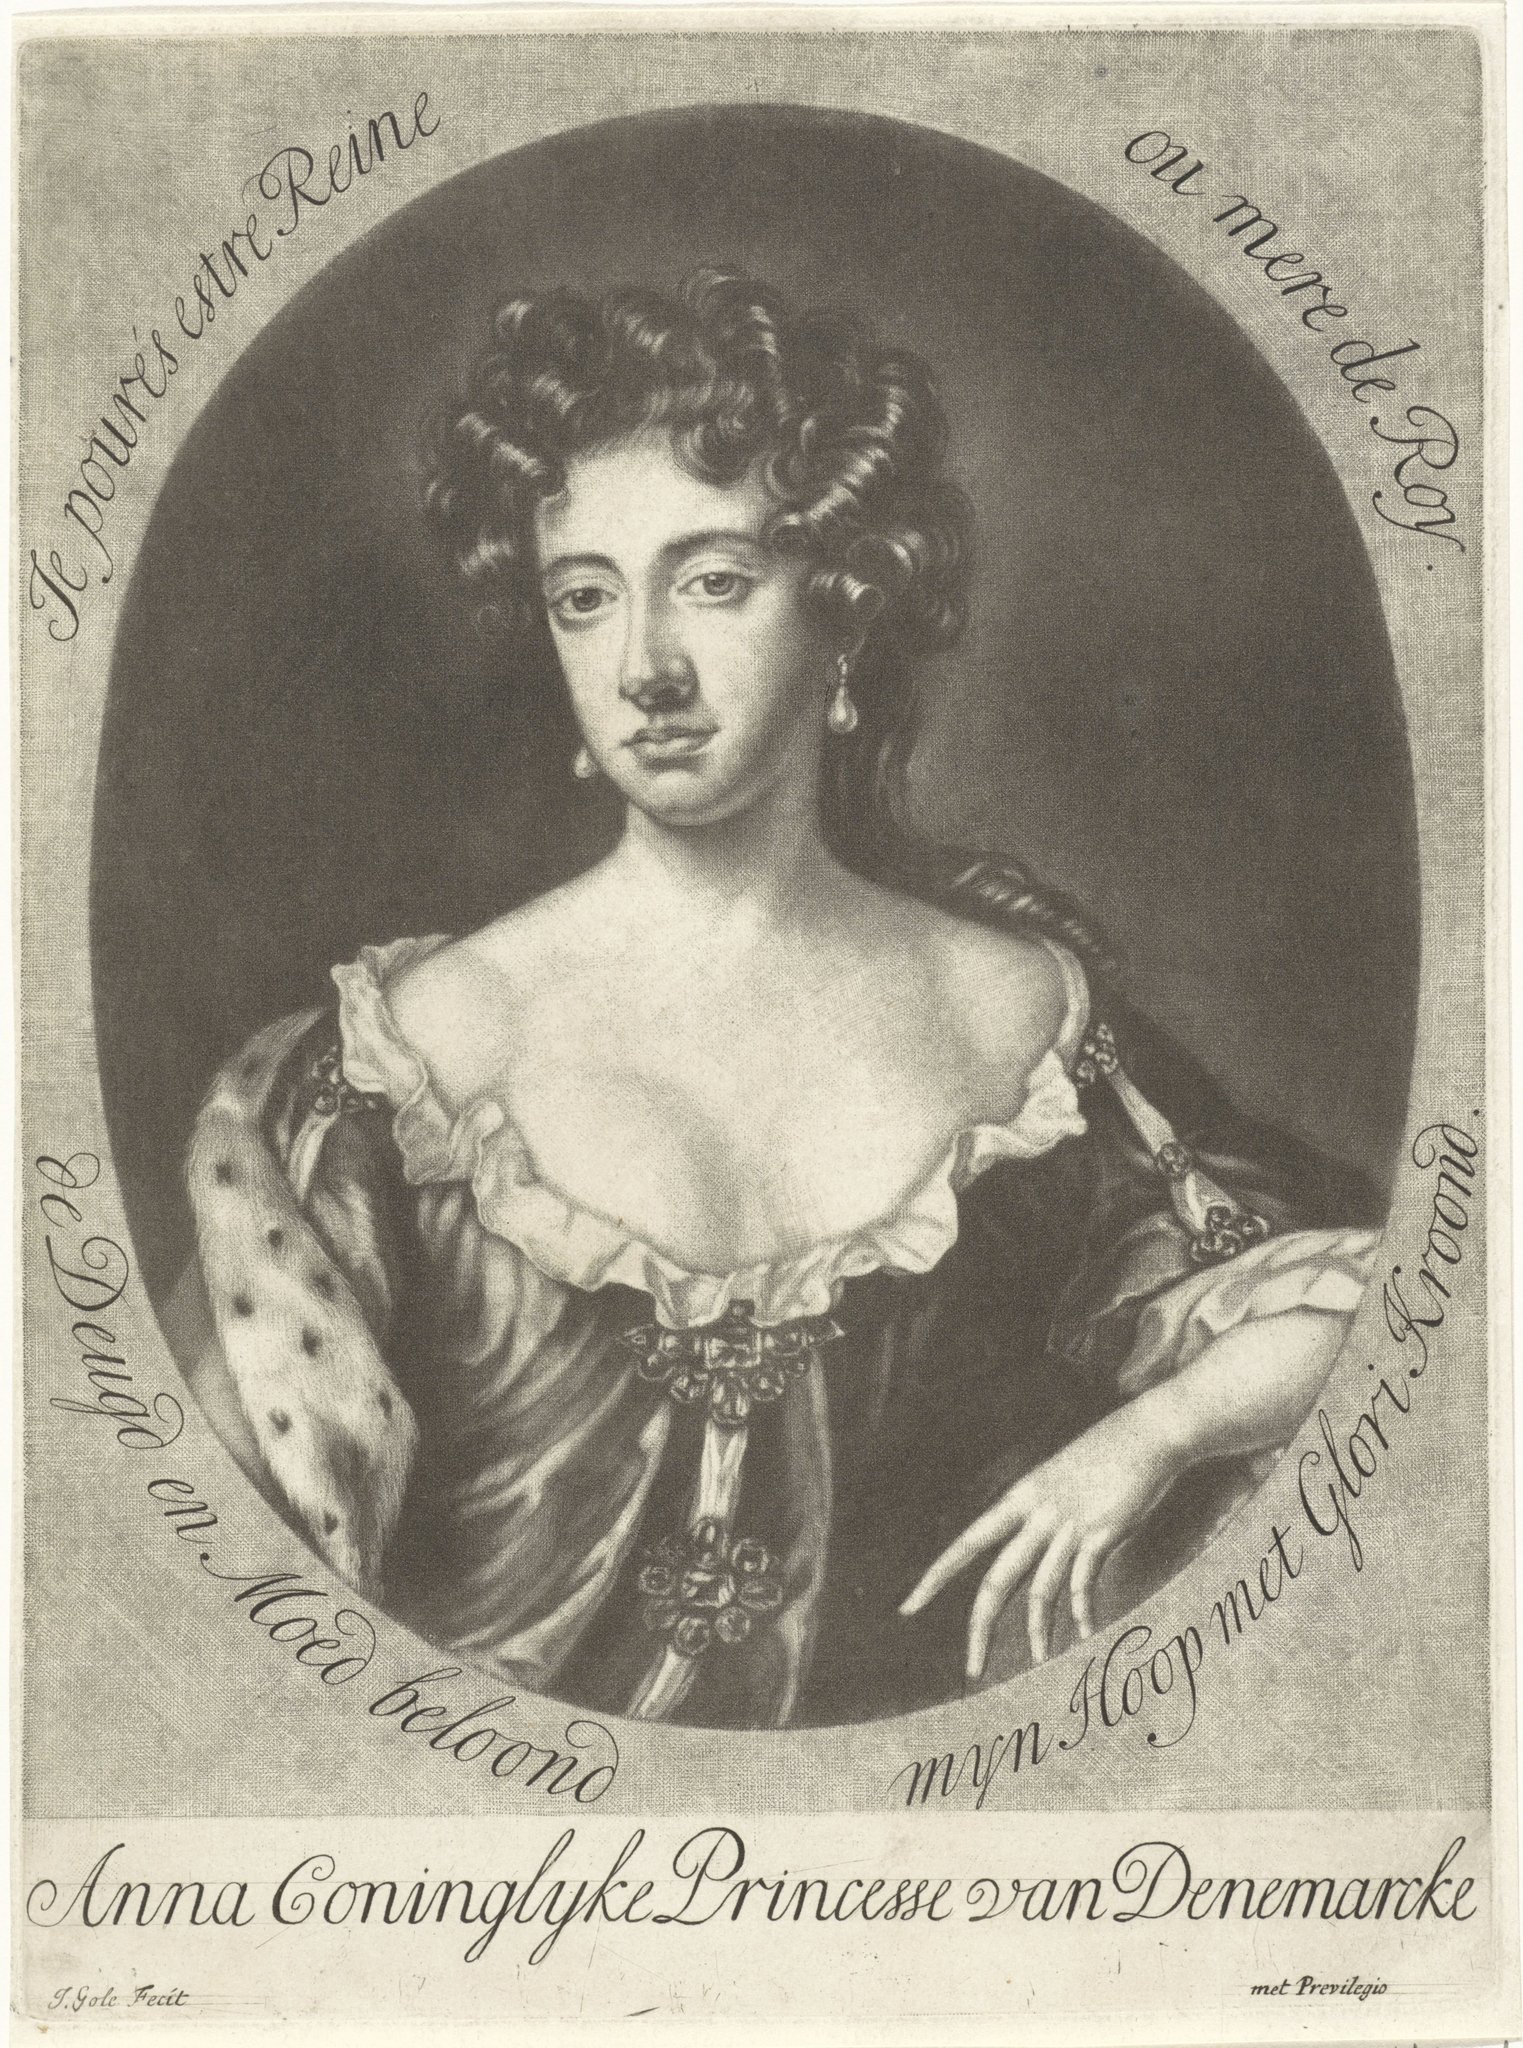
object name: print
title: Portret van Anna Stuart, koningin van Engeland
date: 1683-1724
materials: paper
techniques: engraving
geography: amsterdam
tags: anna stuart (koningin van engeland en schotland), insignia and symbols of sovereignty (crown, diadem, sceptre, orb, seal, standard, cloak, pectoral)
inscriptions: collector's mark: Lugt 2228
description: Anna Stuart, koningin van Engeland, afgebeeld als prinses van Denemarken. Ze was getrouwd met George, prins van Denemarken. Ze draagt de kroningsmantel en heeft in haar hand een scepter.